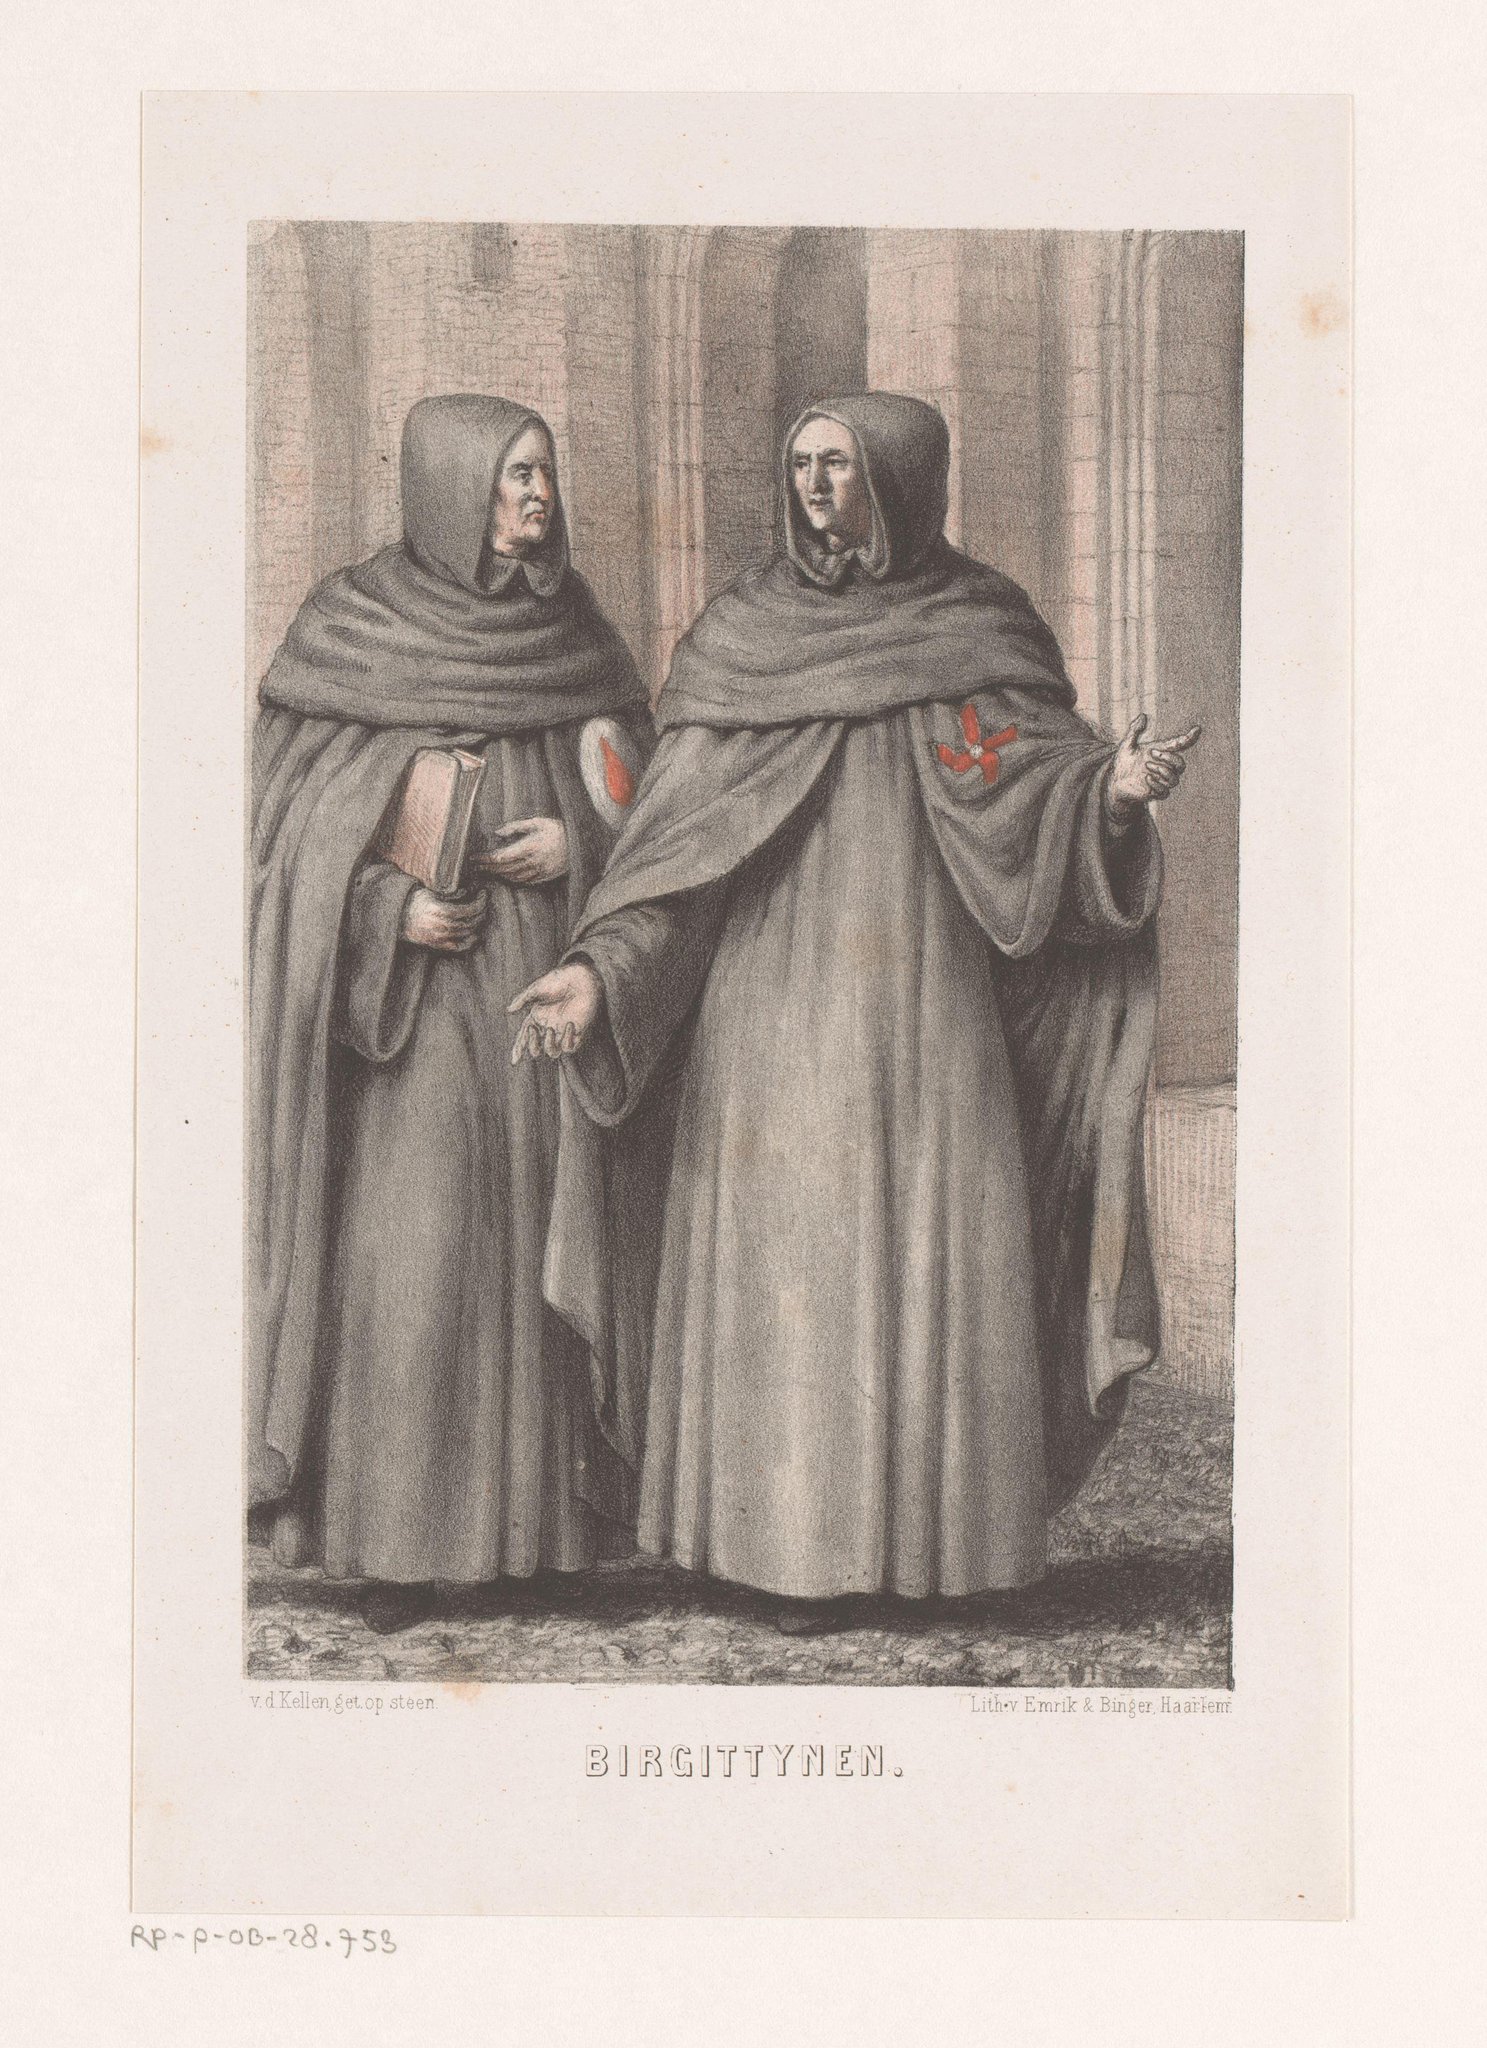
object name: print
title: Birgittynen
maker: david van der kellen (1827-1895)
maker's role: draughtsman, print maker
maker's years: 1827-1895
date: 1859-1864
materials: paper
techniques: tone lithography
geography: haarlem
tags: monk(s), friar(s), monastic orders, monastic life ~ roman catholic church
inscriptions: collector's mark: Lugt 2228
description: Een van de monniken heeft een boek onder zijn arm.